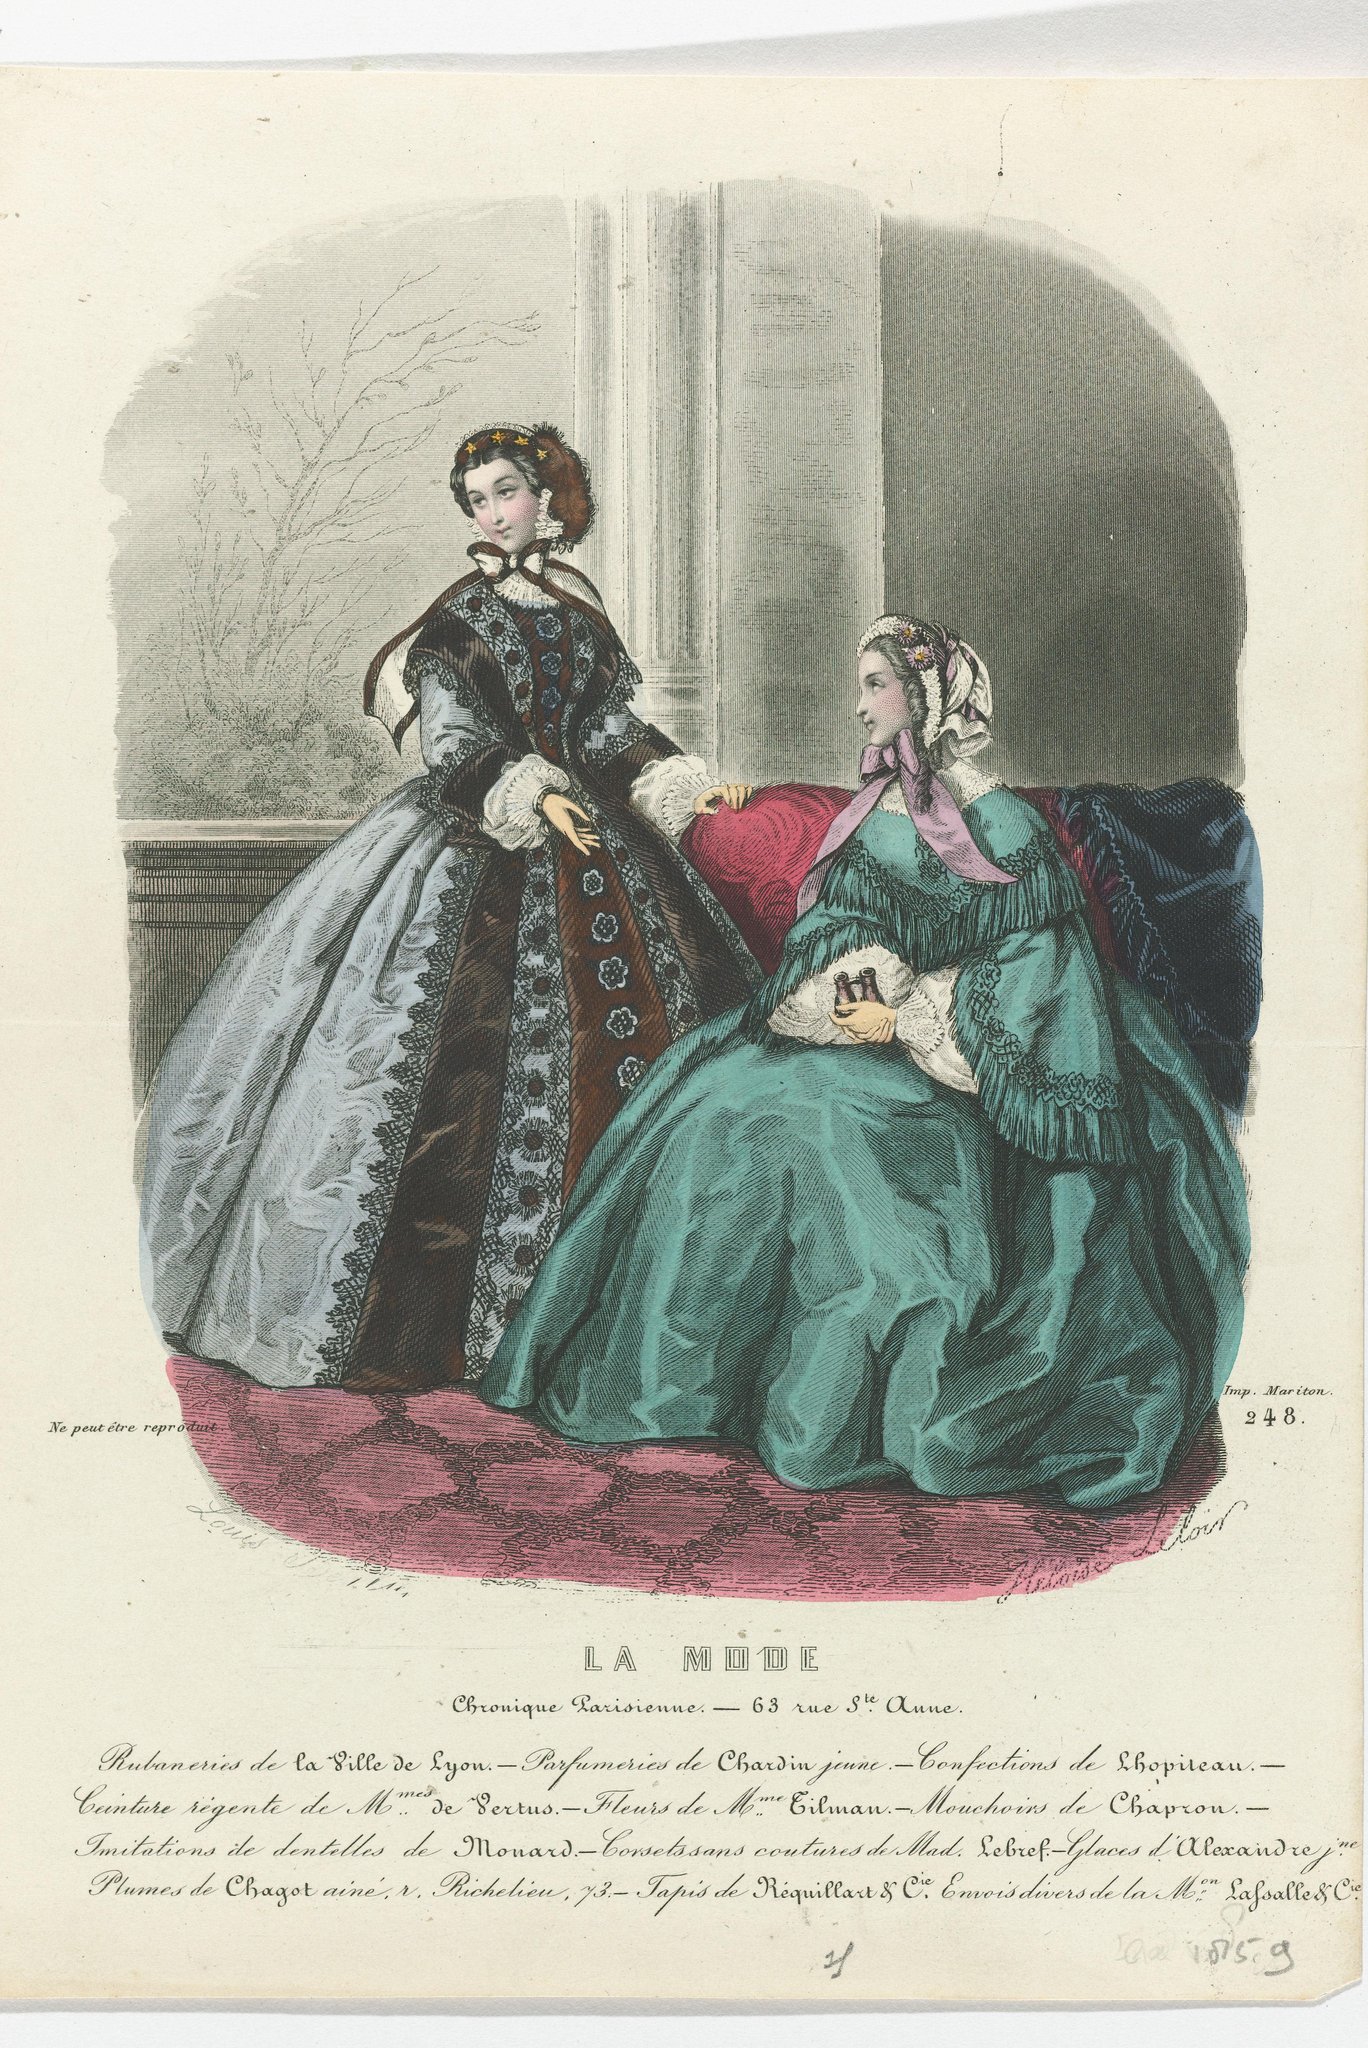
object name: fashion print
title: La Mode, ca. 1860, Pl. 248 : Rubaneries de La Ville de Lyon (...)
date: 1859-1861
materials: paper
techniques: hand coloring, engraving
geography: paris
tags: flowers, lace (+ variant), fashion plates, head-gear: hat (+ women's clothes), gloves, mittens, etc. (+ women's clothes), binoculars, spy-glass, etc., dress, gown (+ girls' clothes)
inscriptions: title: ‘La Mode’, caption: ‘Rubaneries de la Ville de Lyon._ Parfumeries de Chardin jeune._ Cinfections de Lhopteau._ Ceinture régente de M"mes de Vertus._ Fleurs de M"me Tilman._ Mouchoirs de Chapron._ Imitations de dentelles de Monard._ Corsets sans coutures de Mad. Lebref._ Glaces d'Alexandre j.ne. Plumes de Chagot ainé, r. Richelieu, 73._ Tapis de Réquillart & C.ie. Envois divers de la M"on Lassalle & C.ie.’, address: ‘Chronique Parisienne, 63, rue S.te Anne.’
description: Twee vrouwen en een meisje in een park. Onder de voorstelling enkele regels reclametekst voor verschillende producten. Prent uit het modetijdschrift La Mode (1856-1862).